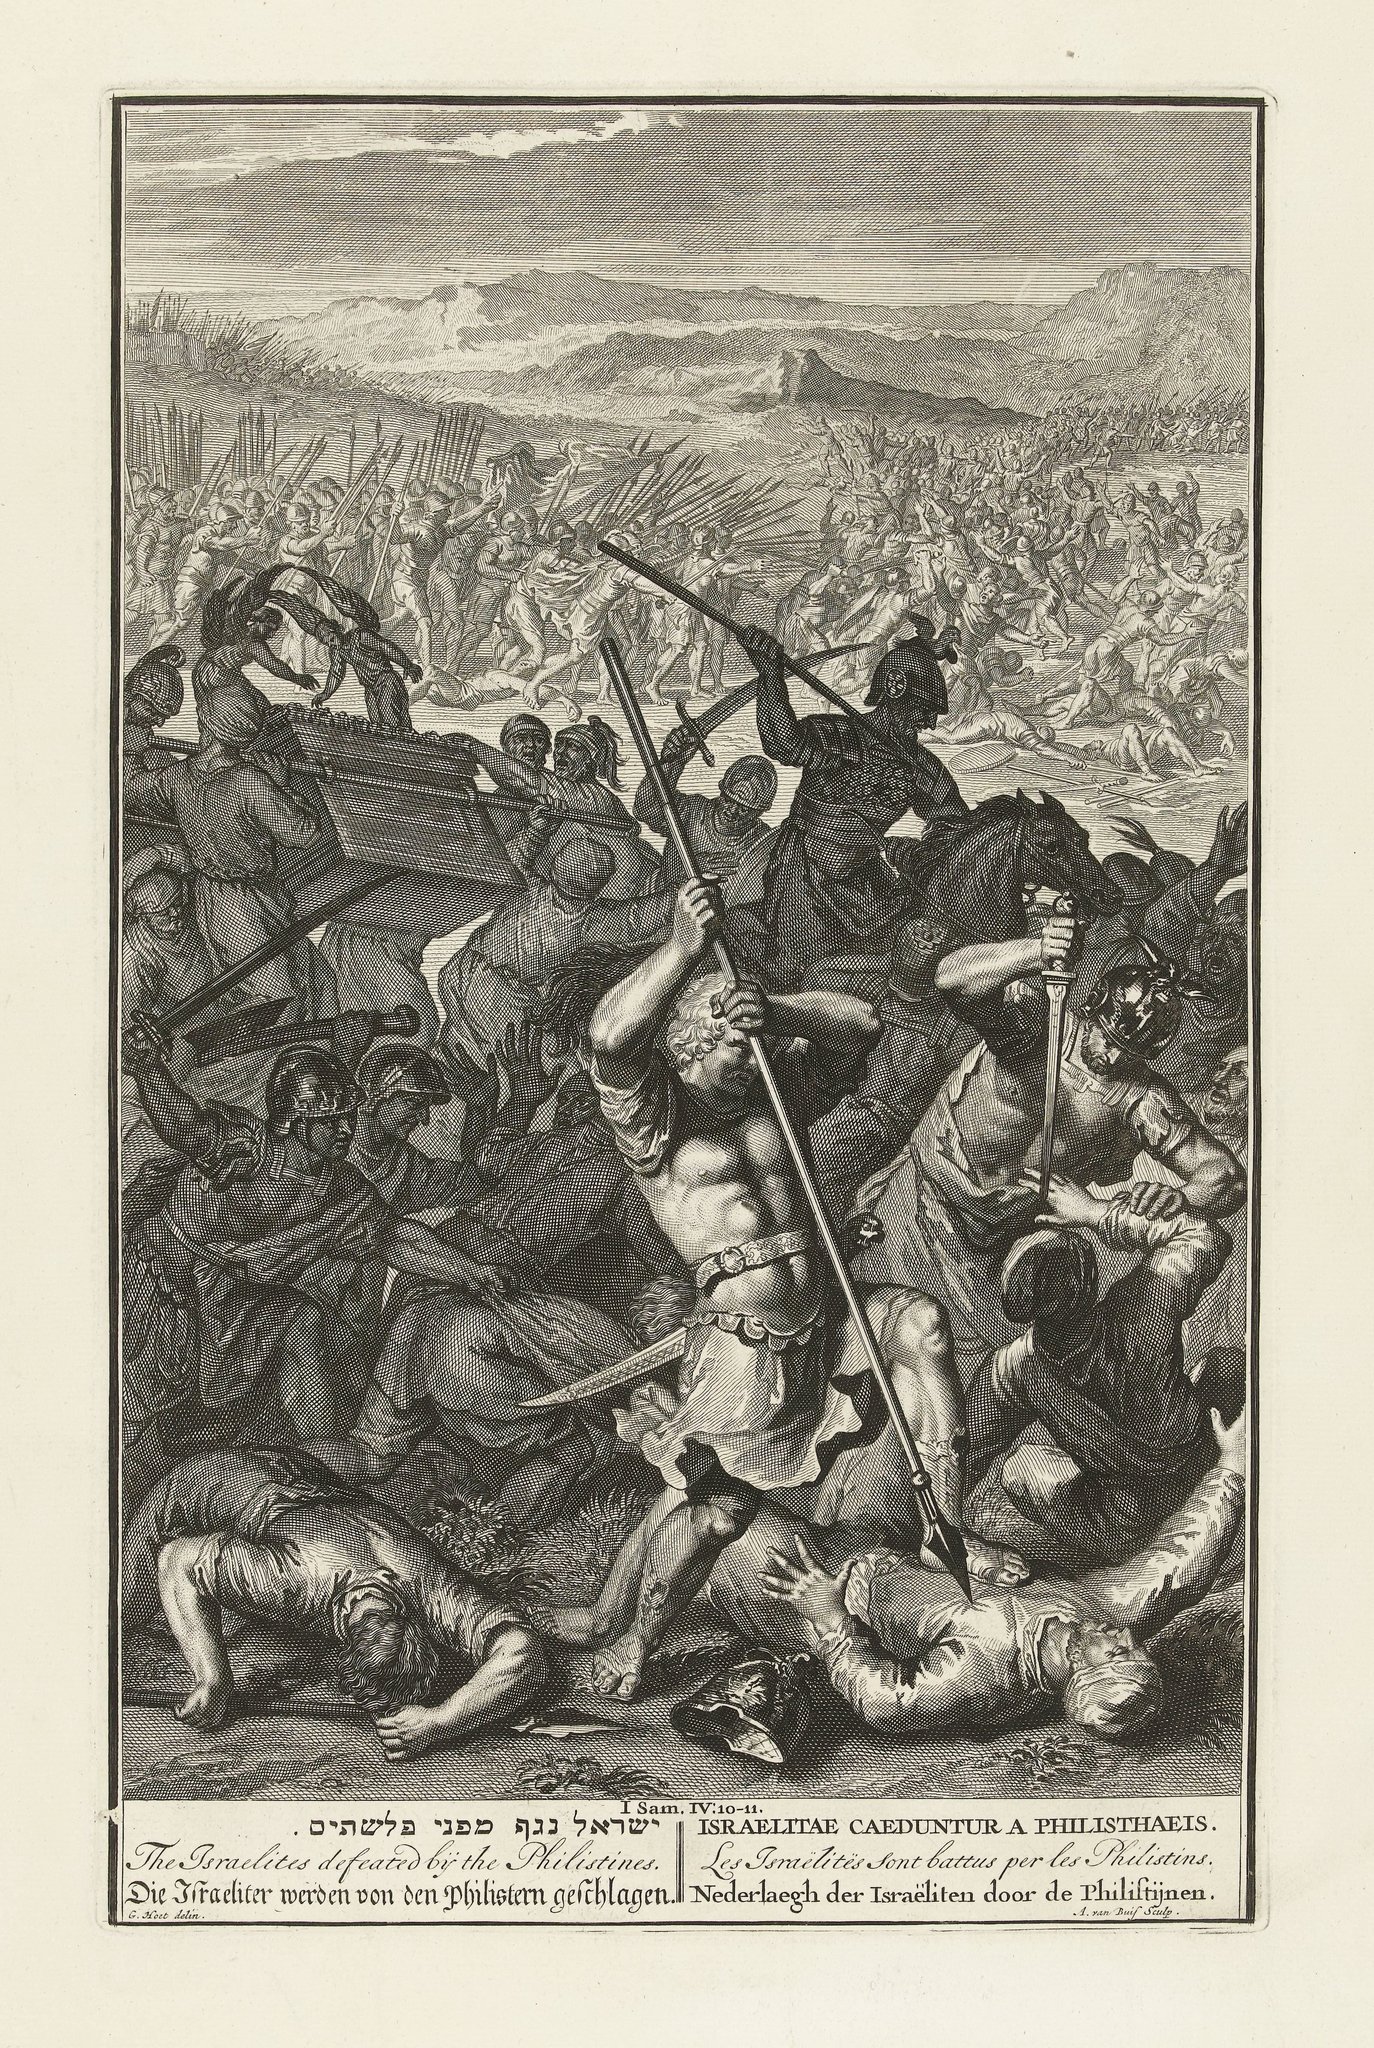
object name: print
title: Nederlaegh der Israëliten door de Philistijnen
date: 1711-1720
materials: paper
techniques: engraving, etching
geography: amsterdam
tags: first battle between the philistines and the israelites at eben-ezer; the israelites defeated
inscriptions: collector's mark: Lugt 2228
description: gemaakt voor: Figures de la Bible, Amsterdam, B. Picart, 1720. ook gebruikt voor: Taferelen der voornaamste geschiedenissen van het Oude en Nieuwe Testament, en andere boeken, bij de Heilige Schrift gevoegt. Den Haag: Pieter de Hondt, 1728.